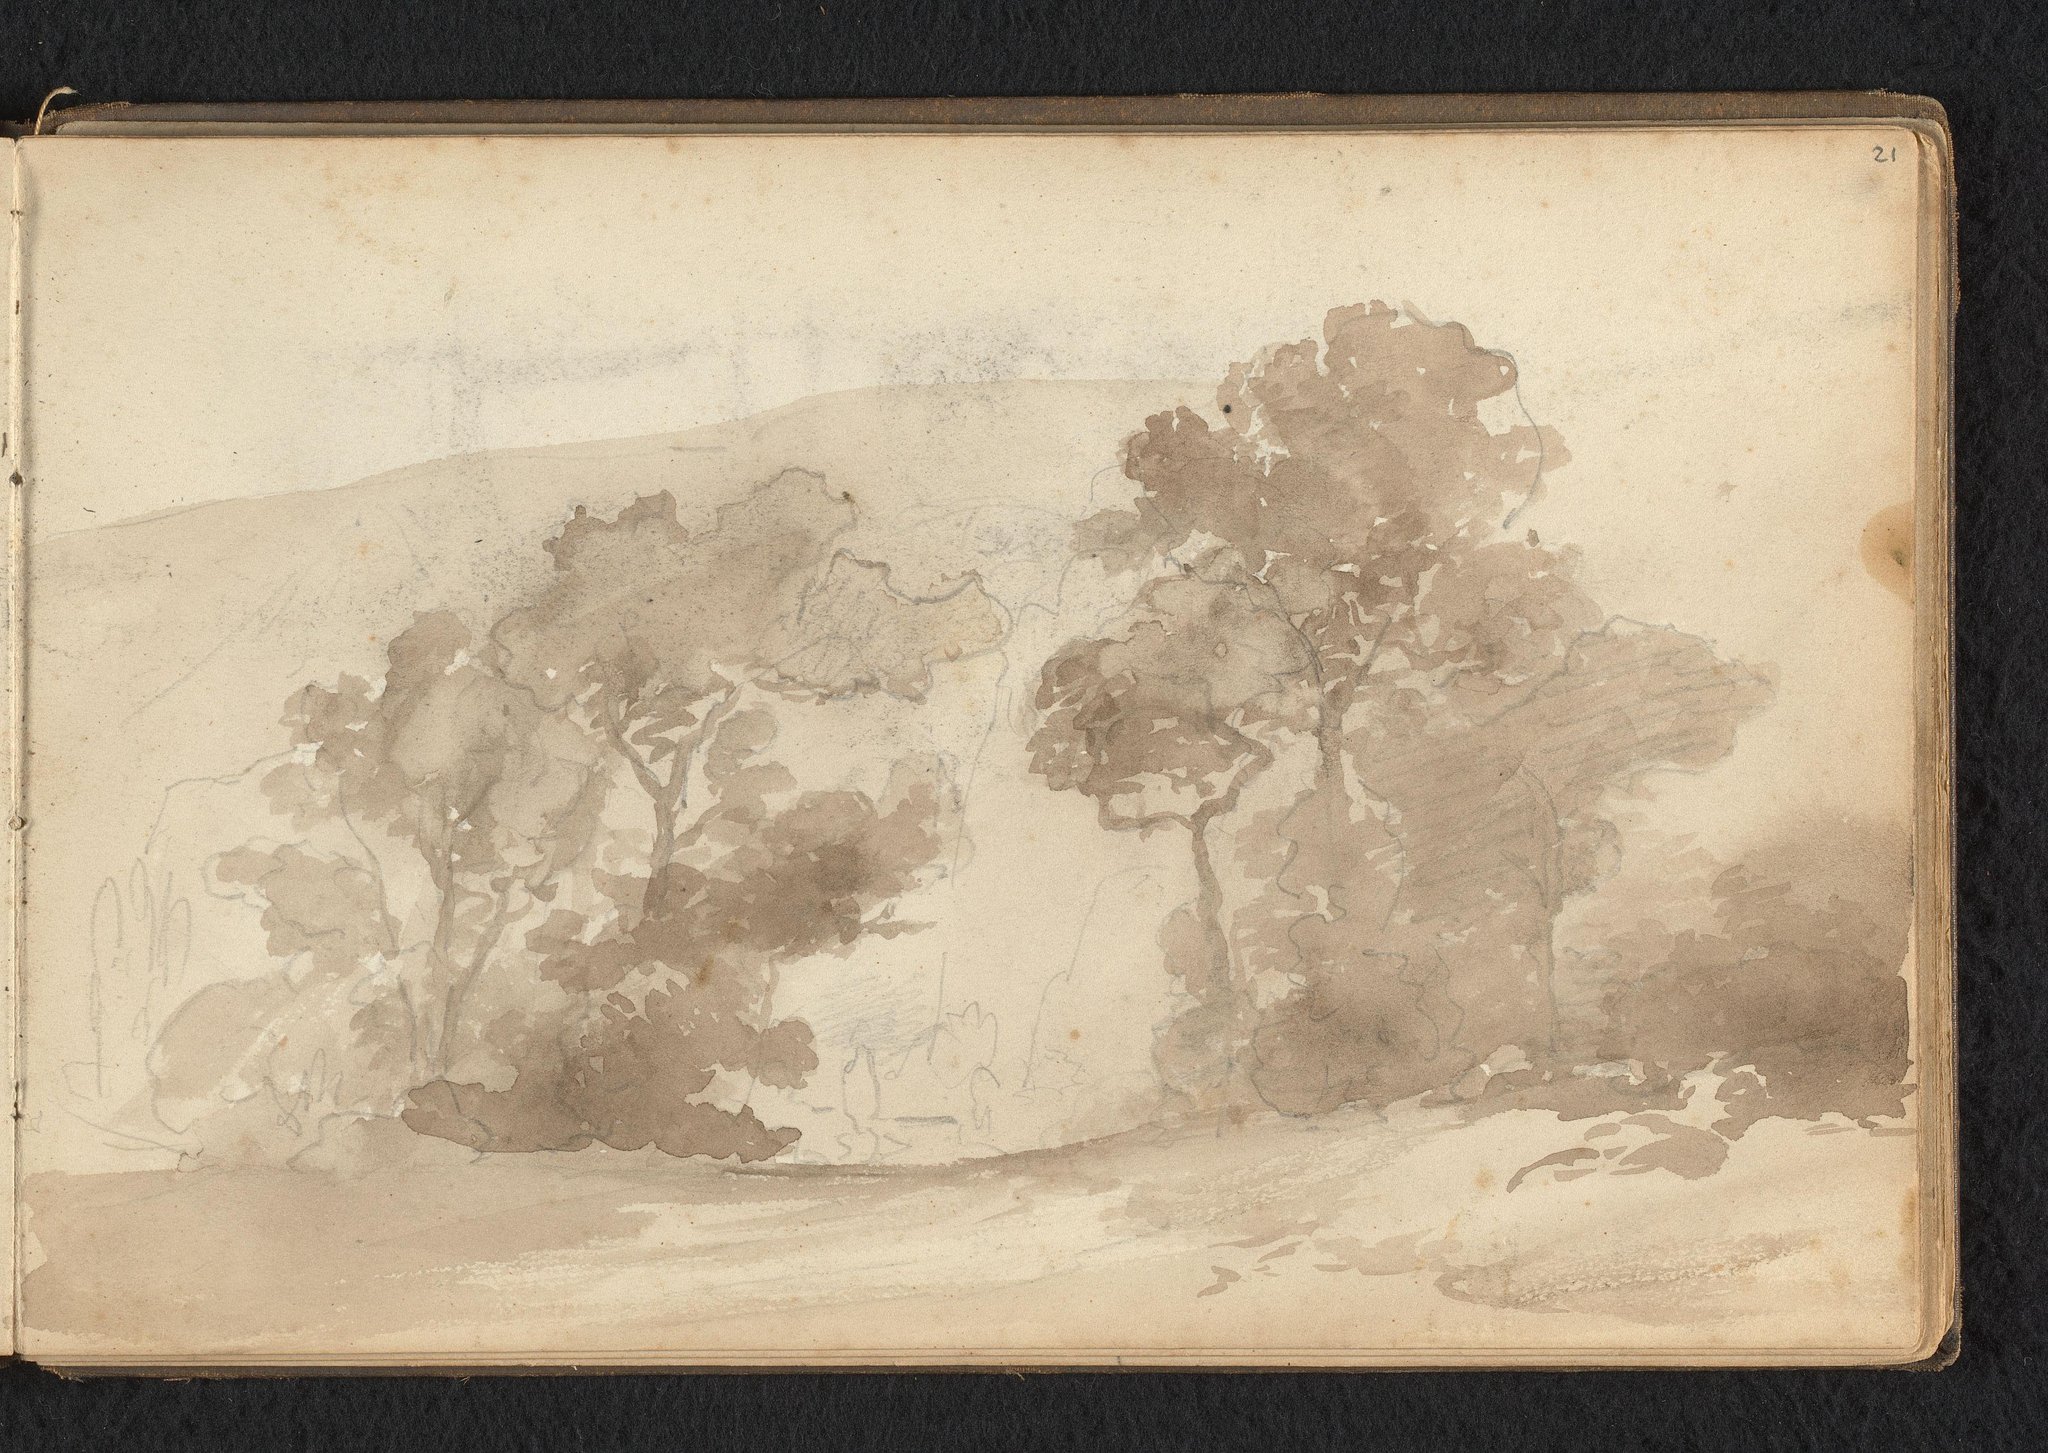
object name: sketchbook leaf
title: Heuvelig boslandschap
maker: jan bedijs tom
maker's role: draughtsman, painter, print maker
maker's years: 1813-1894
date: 1823-1894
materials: paper, pencil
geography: the hague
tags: low hill country, forest path or lane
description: Pagina 21 recto uit een schetsboek met 37 bladen.